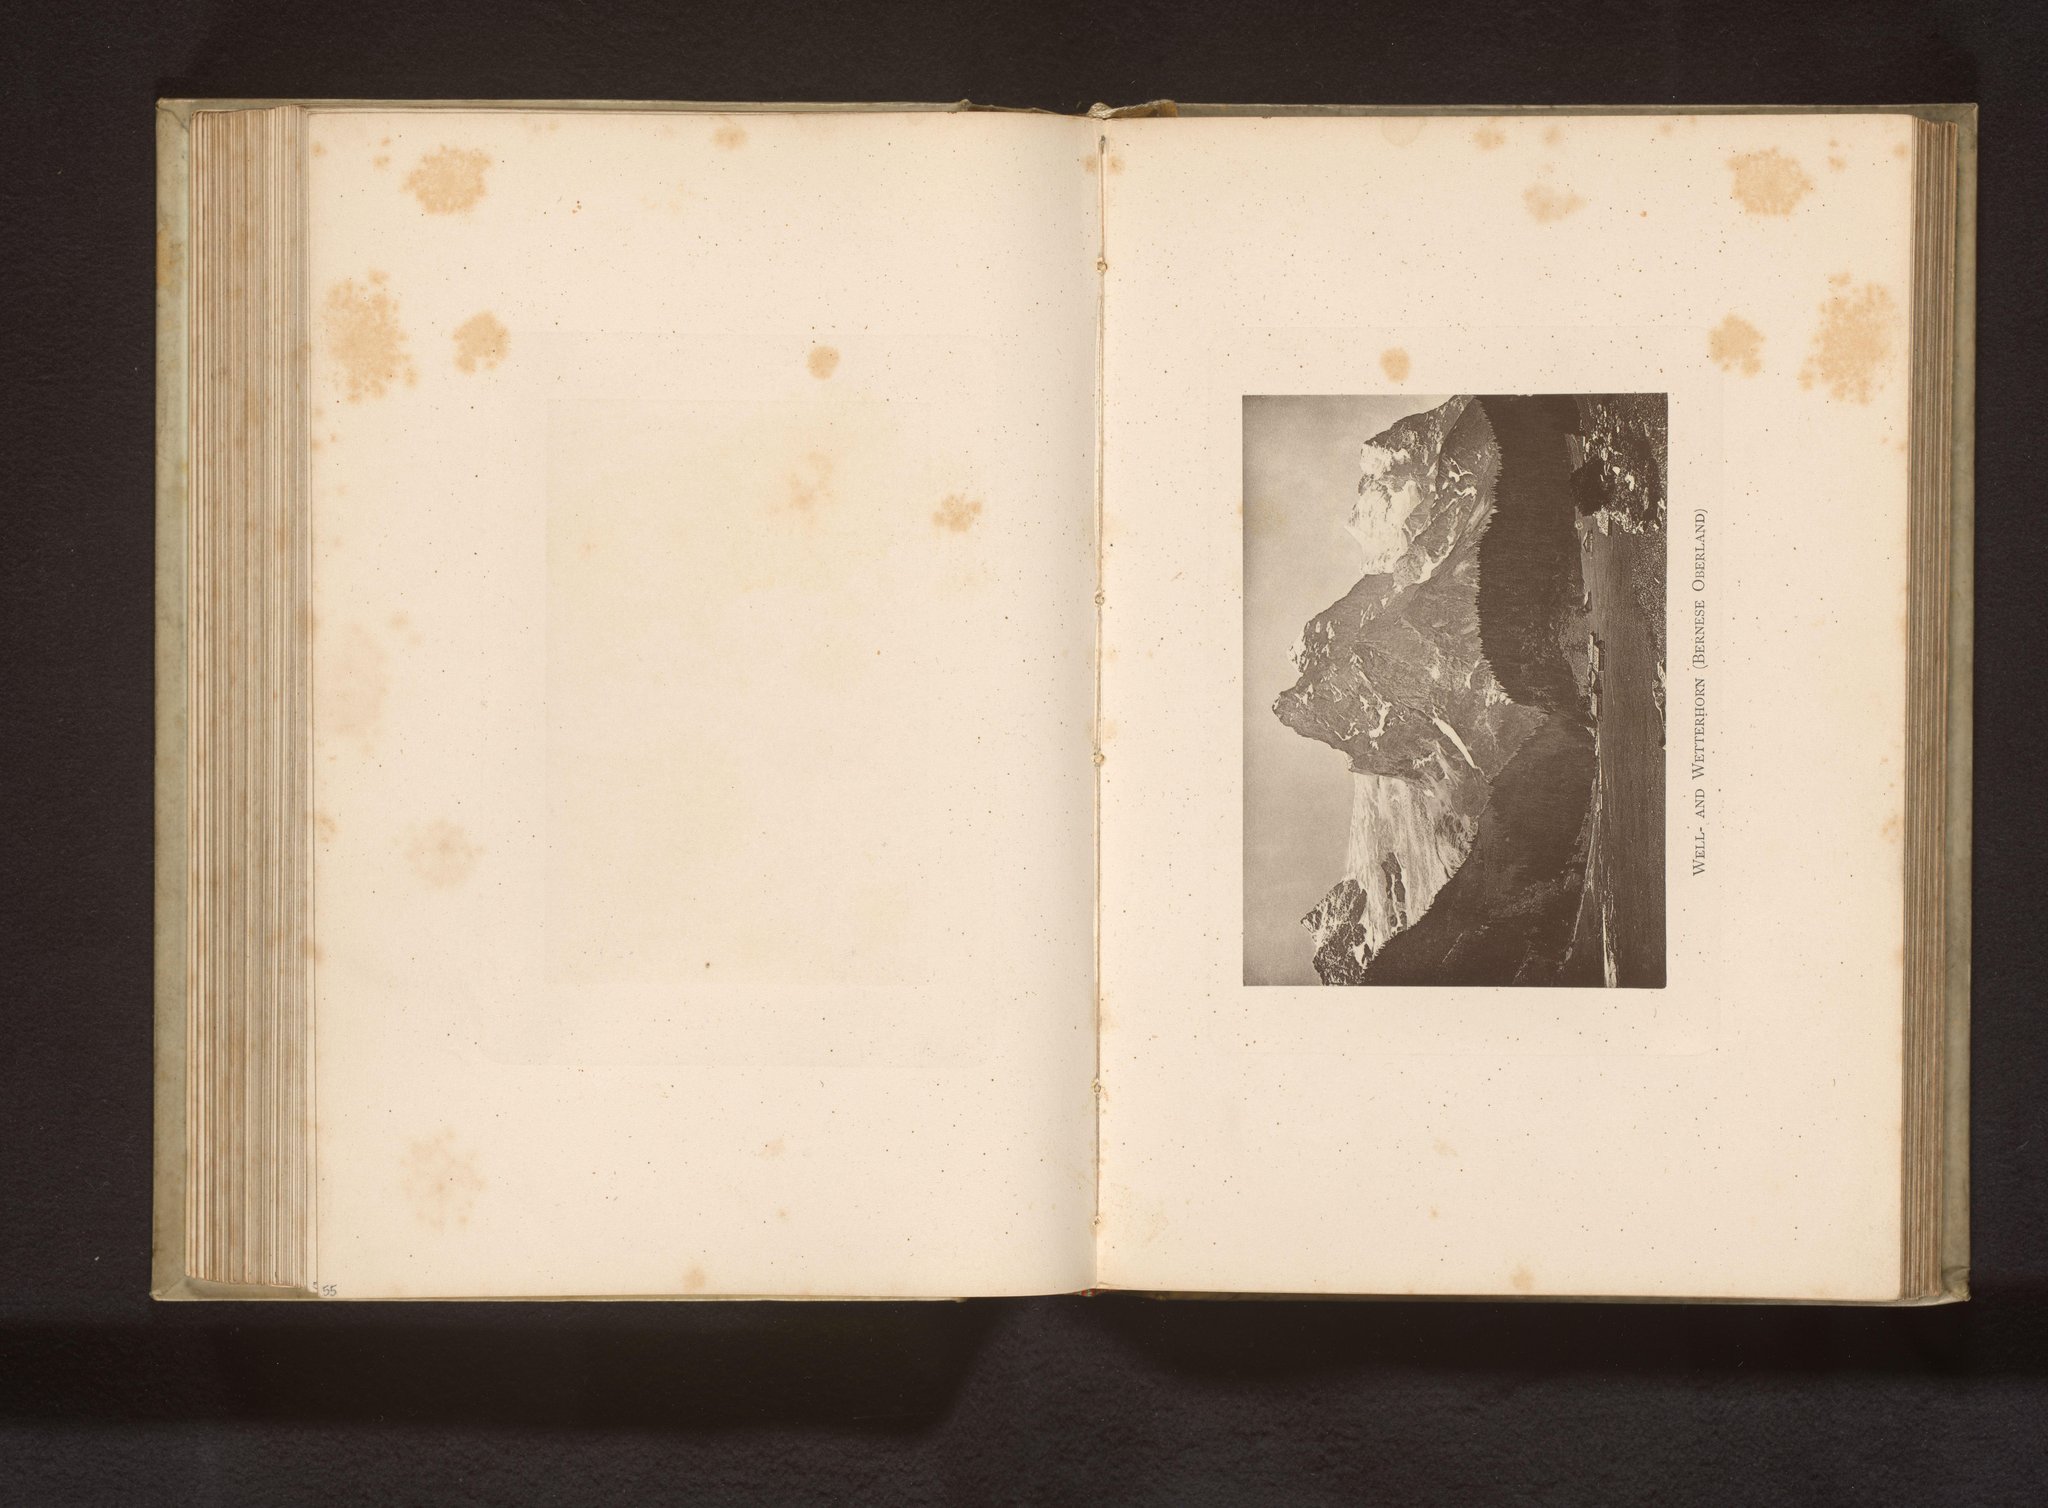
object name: page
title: Well-and Wetterhorn (Bernese Oberland)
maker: Anonymous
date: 1874-1884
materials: paper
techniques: photograph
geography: bern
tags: mountains